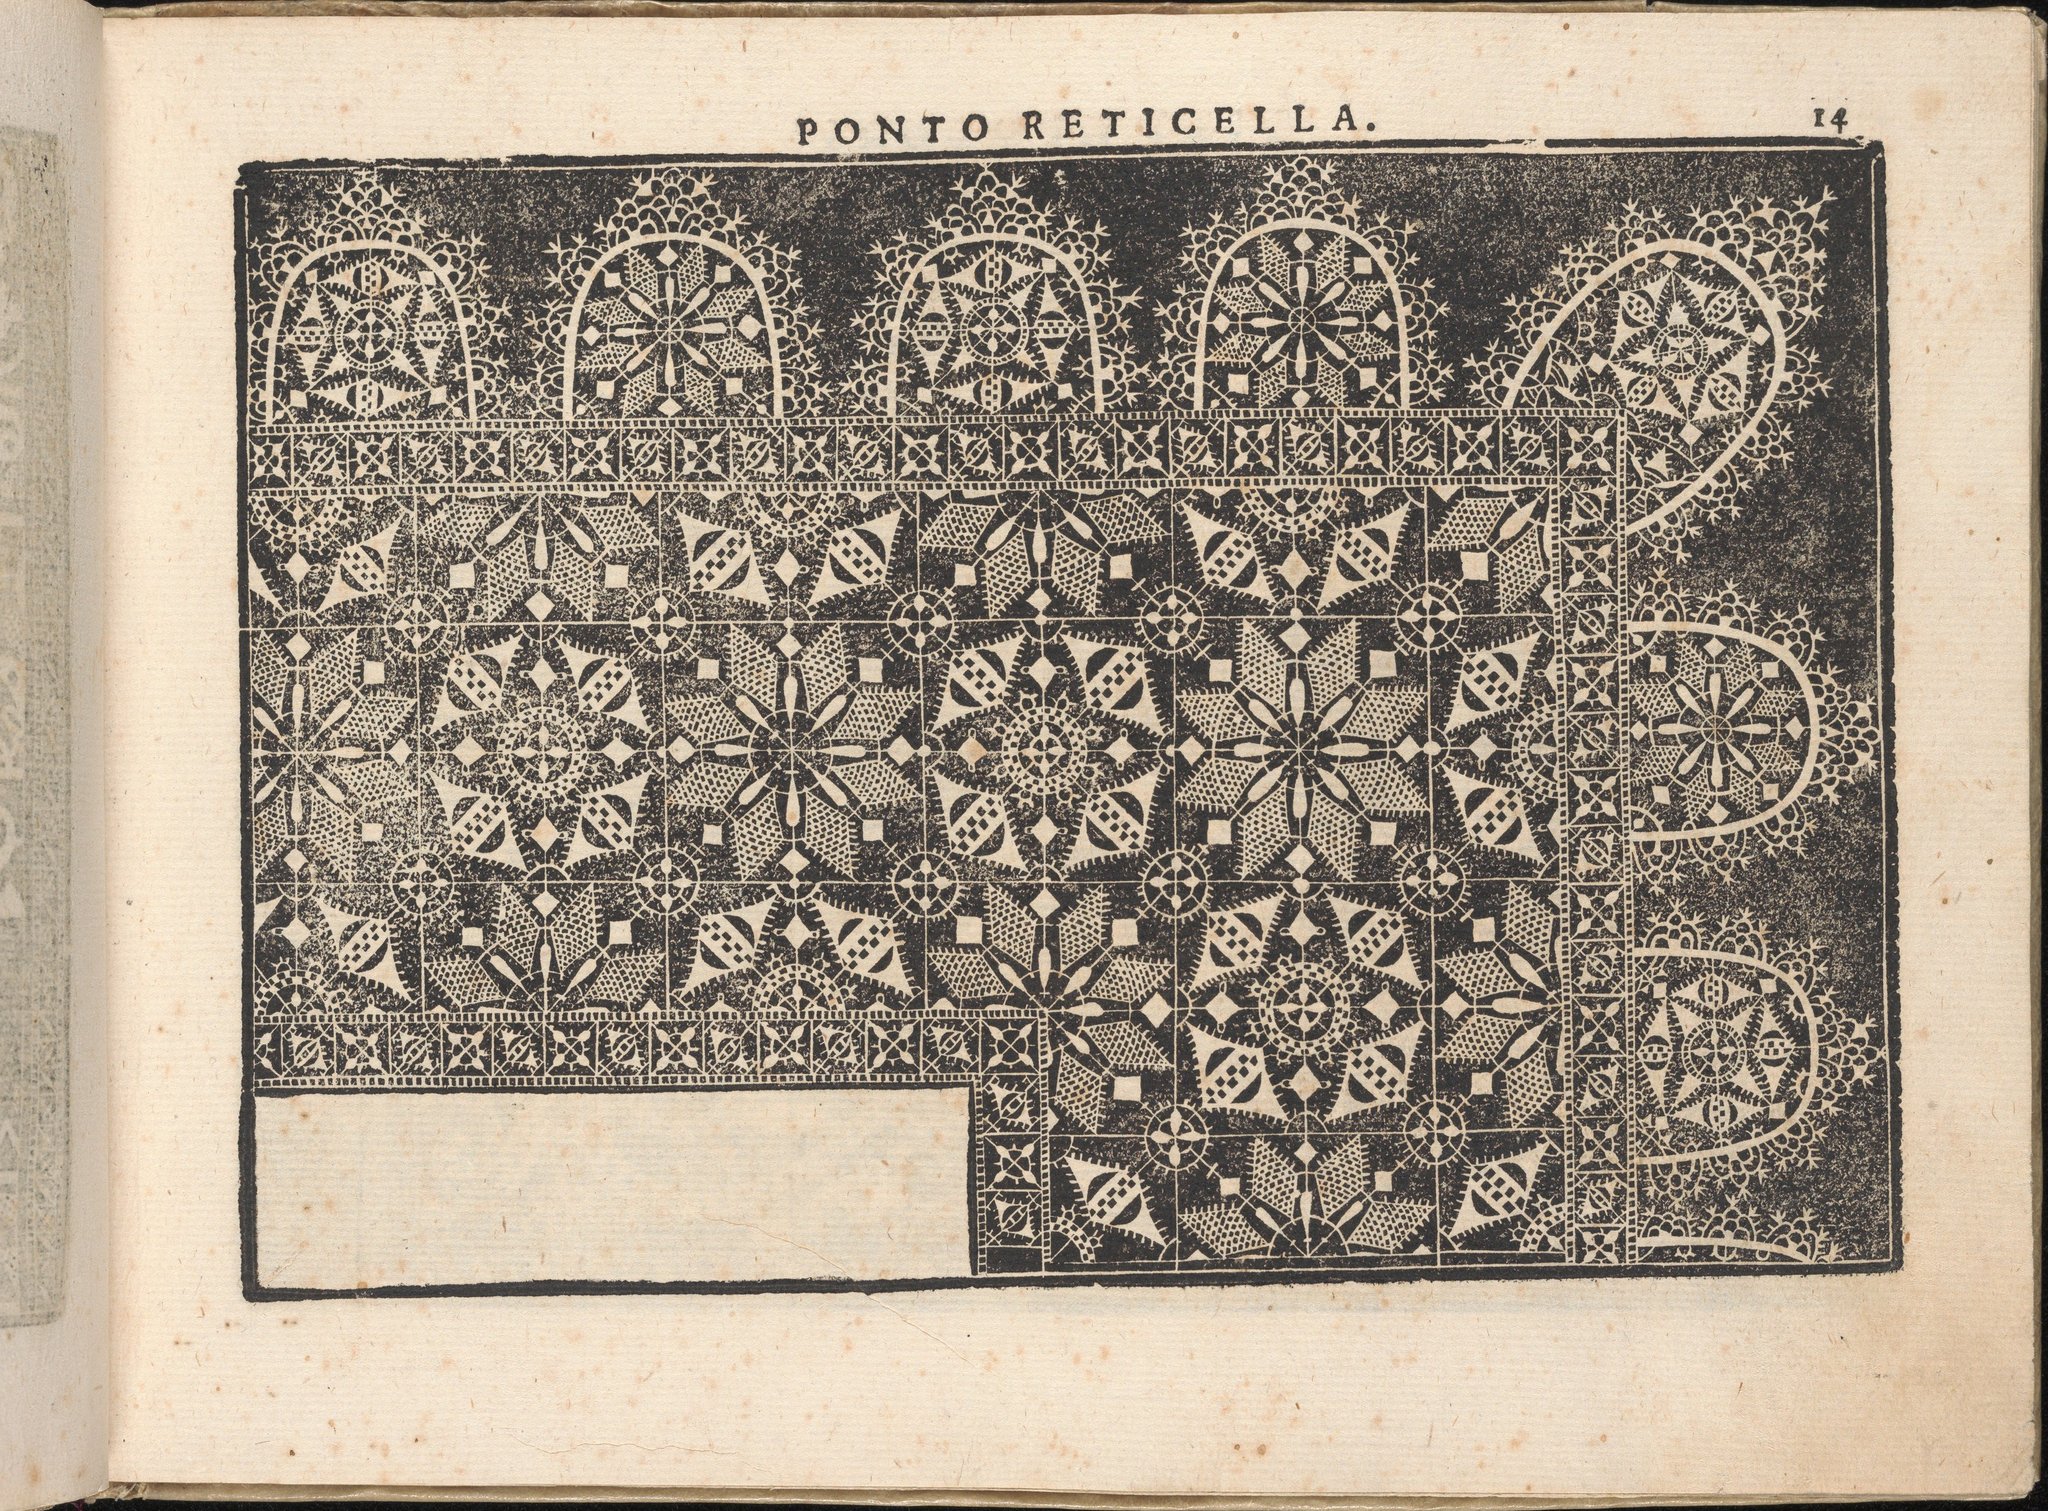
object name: book print ornament architecture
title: Fiore D'Ogni Virtu Per le Nobili Et Honeste Matrone, page 14 (recto)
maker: isabella catanea parasole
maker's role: designer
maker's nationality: italian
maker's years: 1565-1625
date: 1610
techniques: woodcut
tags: ornament